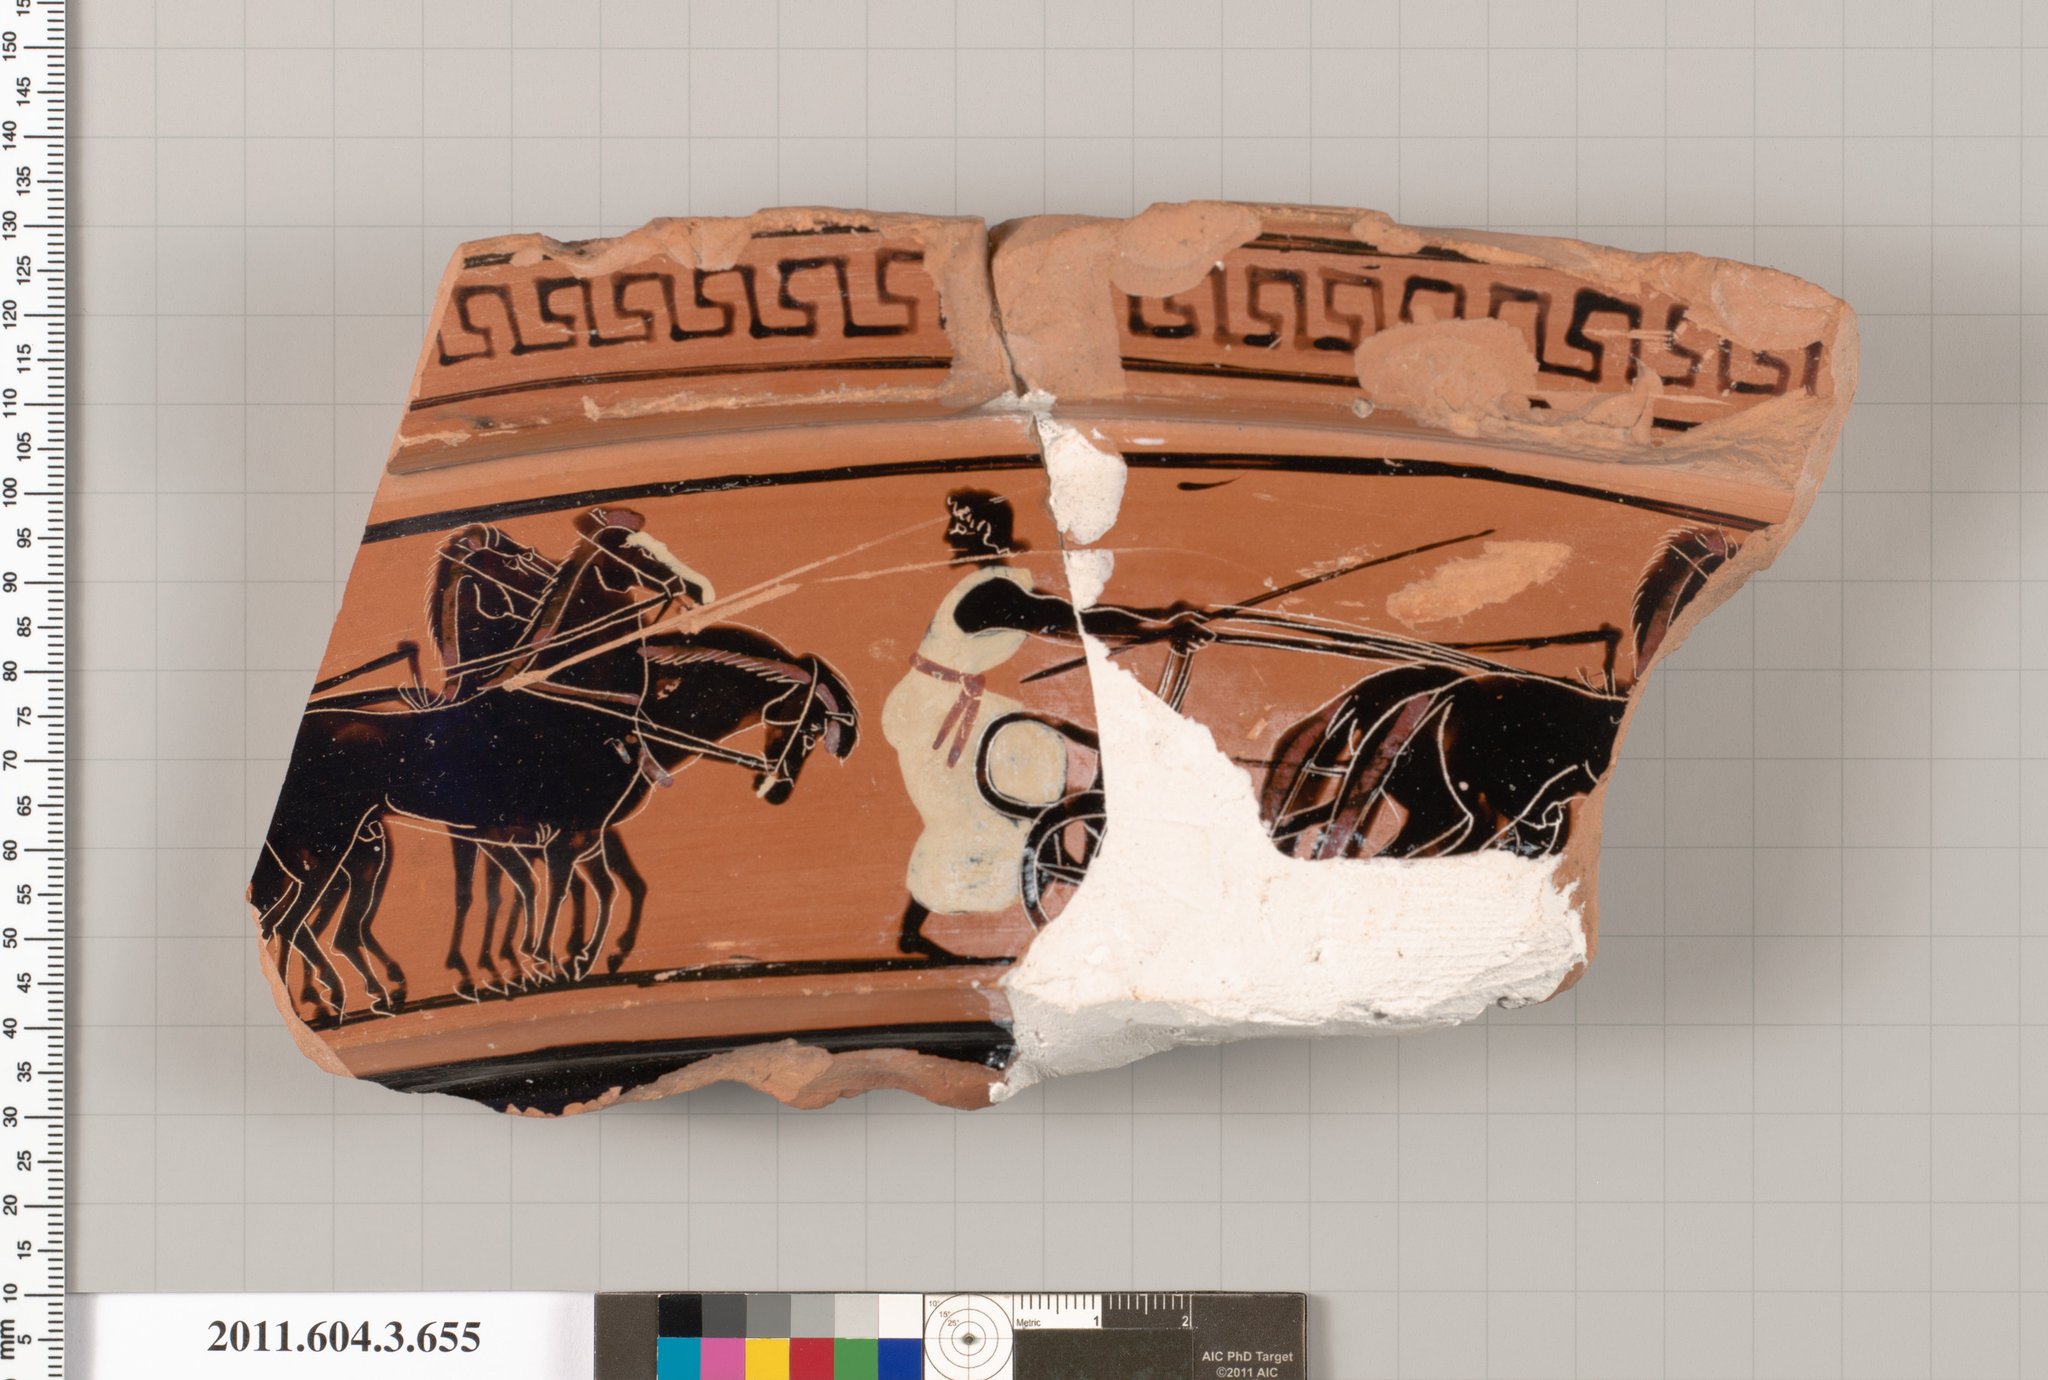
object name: volute krater fragment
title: Terracotta fragment of a volute-krater (bowl for mixing wine and water)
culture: greek, attic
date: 534-501 BCE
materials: terracotta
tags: men,horses,chariots